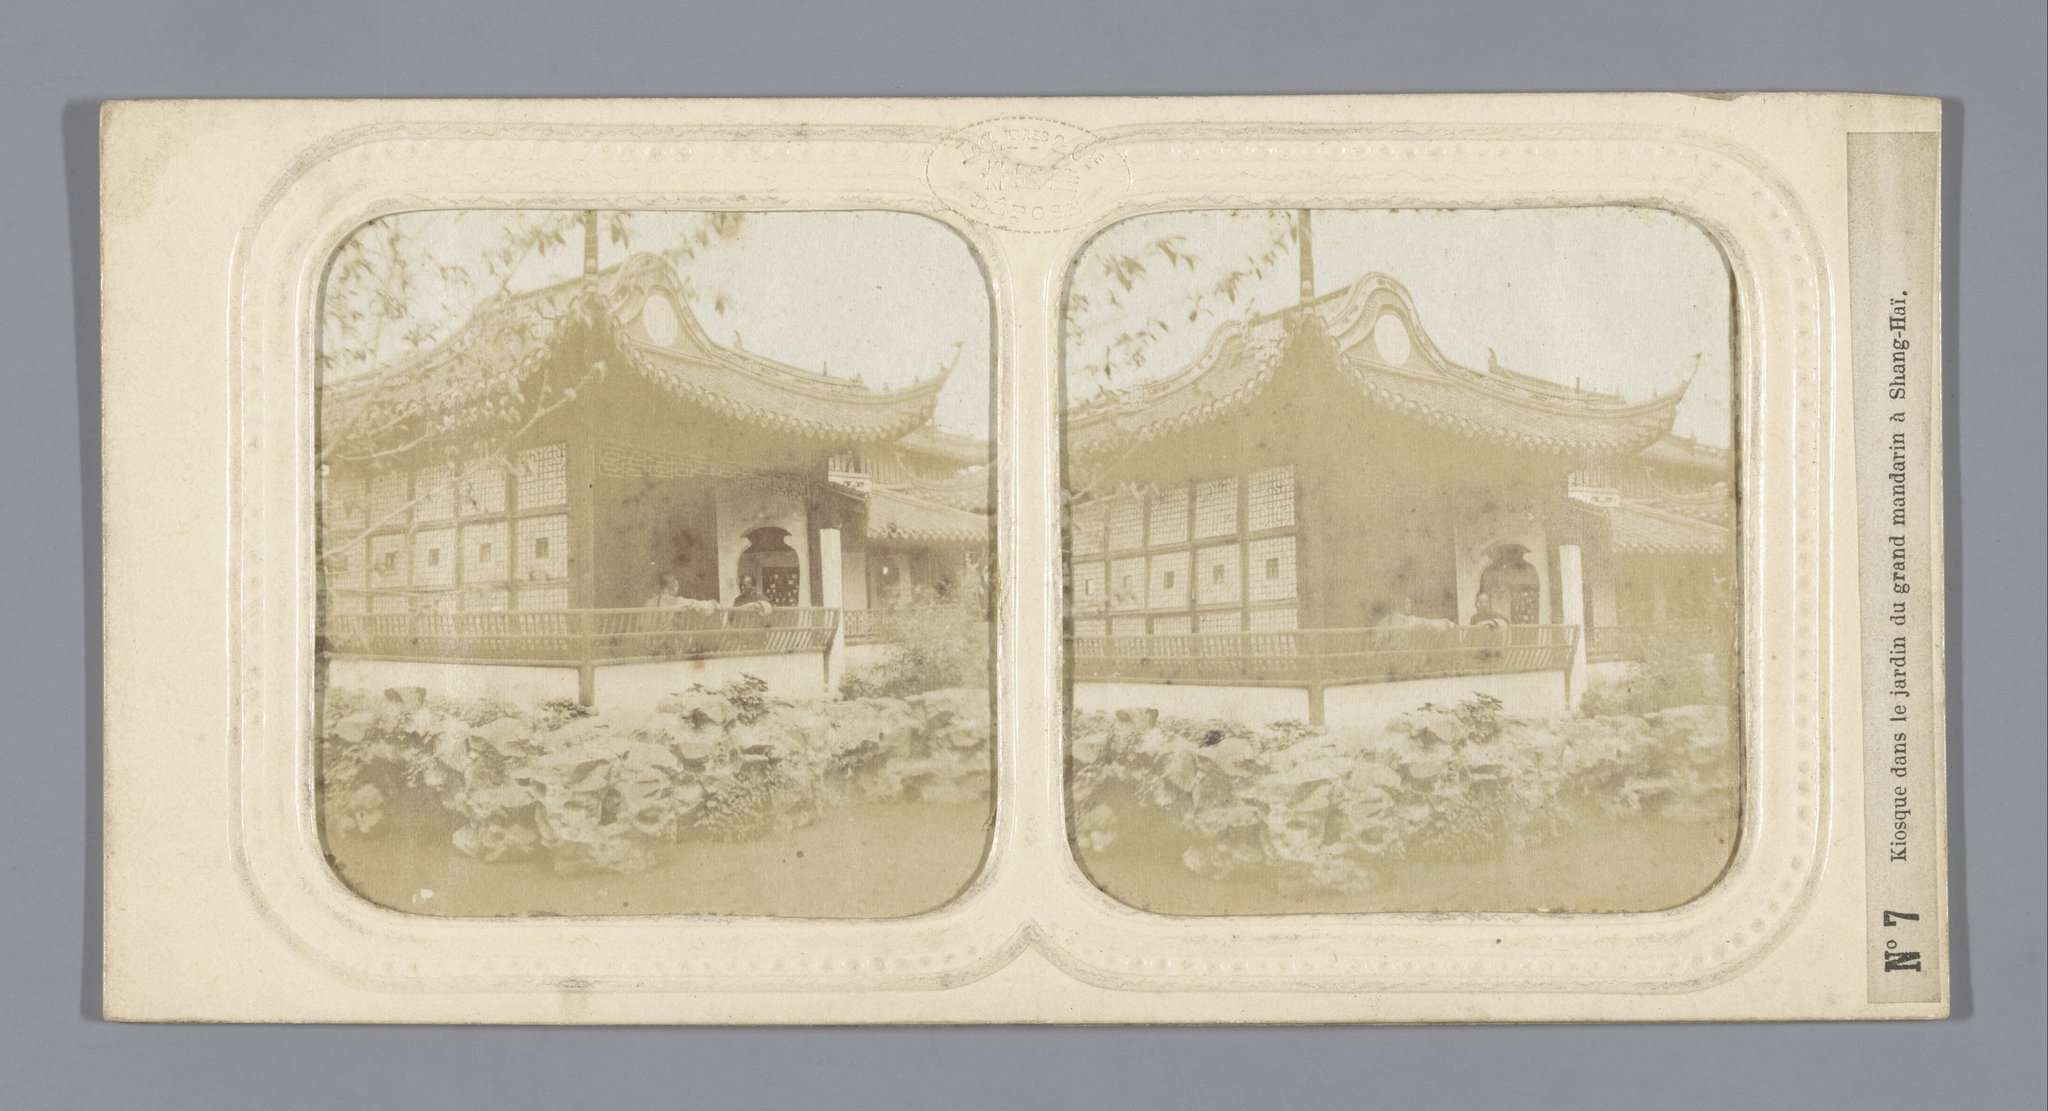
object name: tissue stereograph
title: Paviljoen in de Yu-tuin in Shanghai, China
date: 1855-1875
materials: cardboard, paper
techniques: albumen print, hand coloring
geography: shanghai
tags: temple, shrine ~ traditional chinese religions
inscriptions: number: ‘No 7’